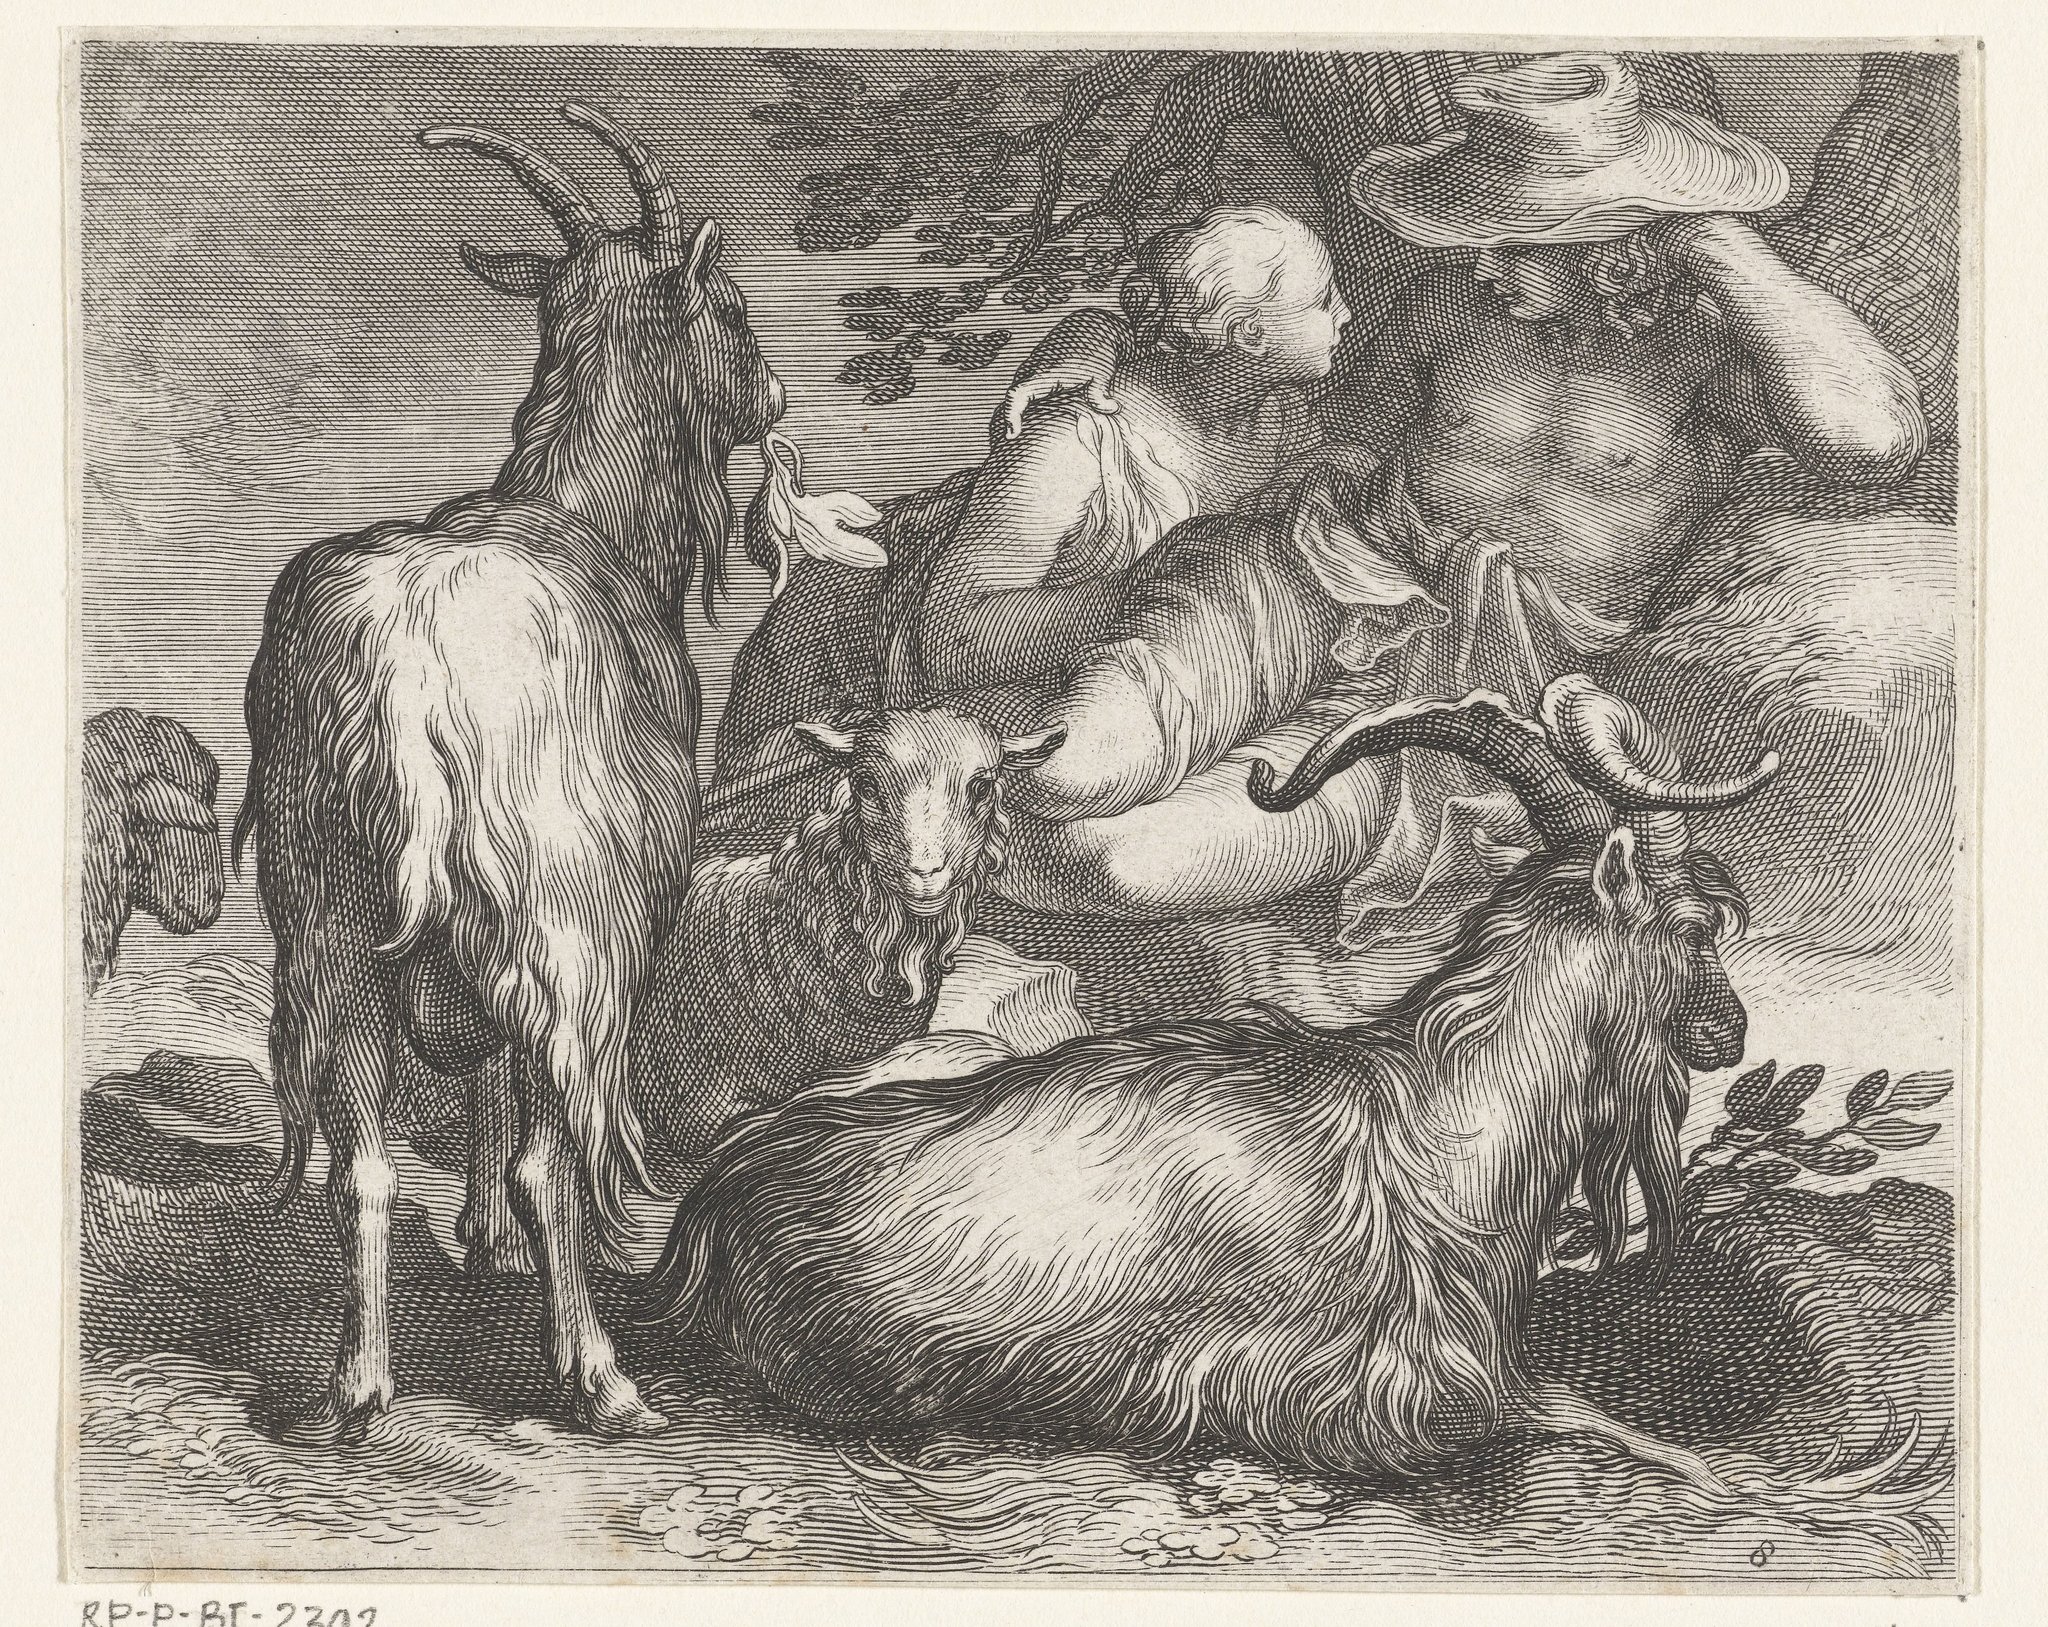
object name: print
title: Herder en herderin met geiten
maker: boëtius adamsz. bolswert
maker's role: print maker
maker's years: 1580-1633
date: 1611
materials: paper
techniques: engraving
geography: amsterdam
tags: herding, herdsman, herdswoman, shepherd, shepherdess, cowherd, etc., pastorals, arcadian scenes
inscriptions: collector's mark: Lugt 240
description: Prent uit serie met veertien prenten zogenaamde Pastoralen naar ontwerp van Abraham Bloemaert.